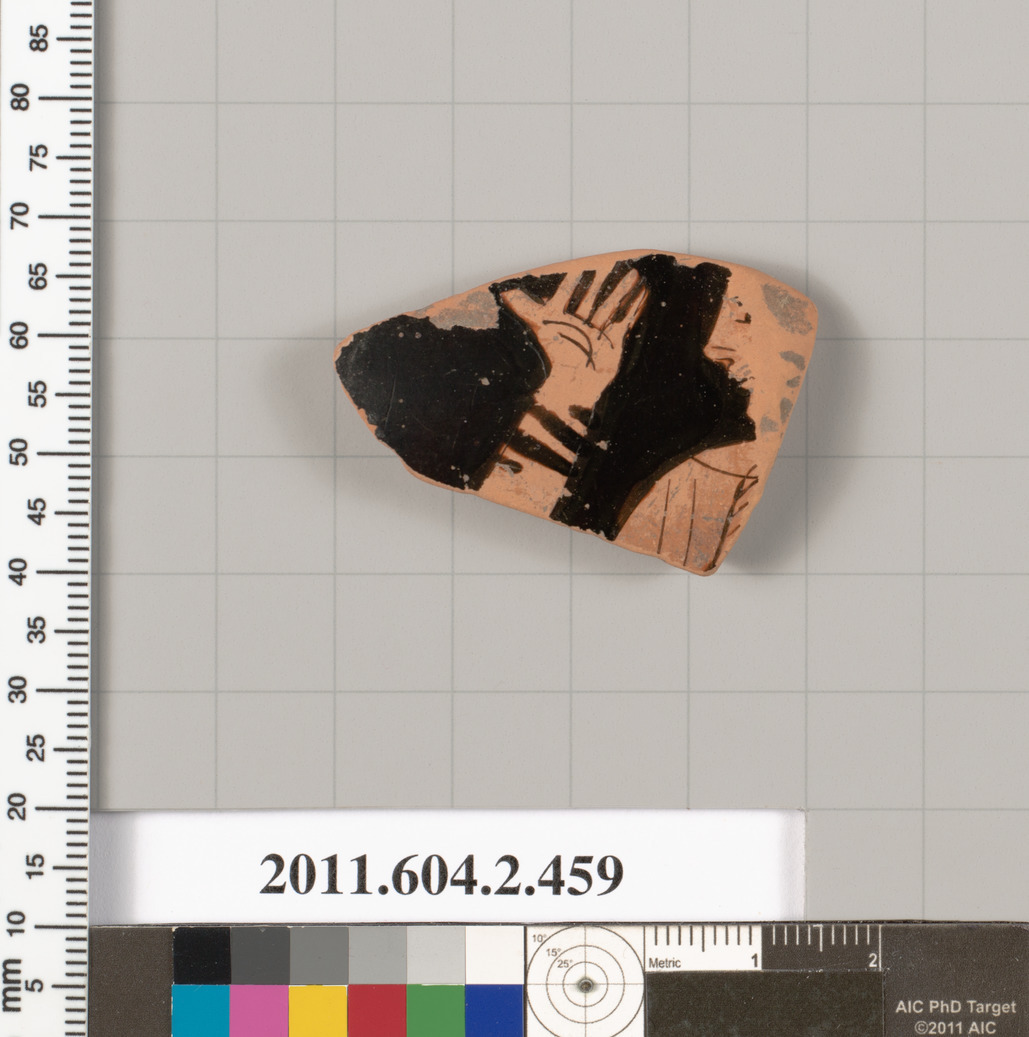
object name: column krater fragment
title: Terracotta fragment of a column-krater (bowl for mixing wine and water)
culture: greek, attic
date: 460-440 BCE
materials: terracotta